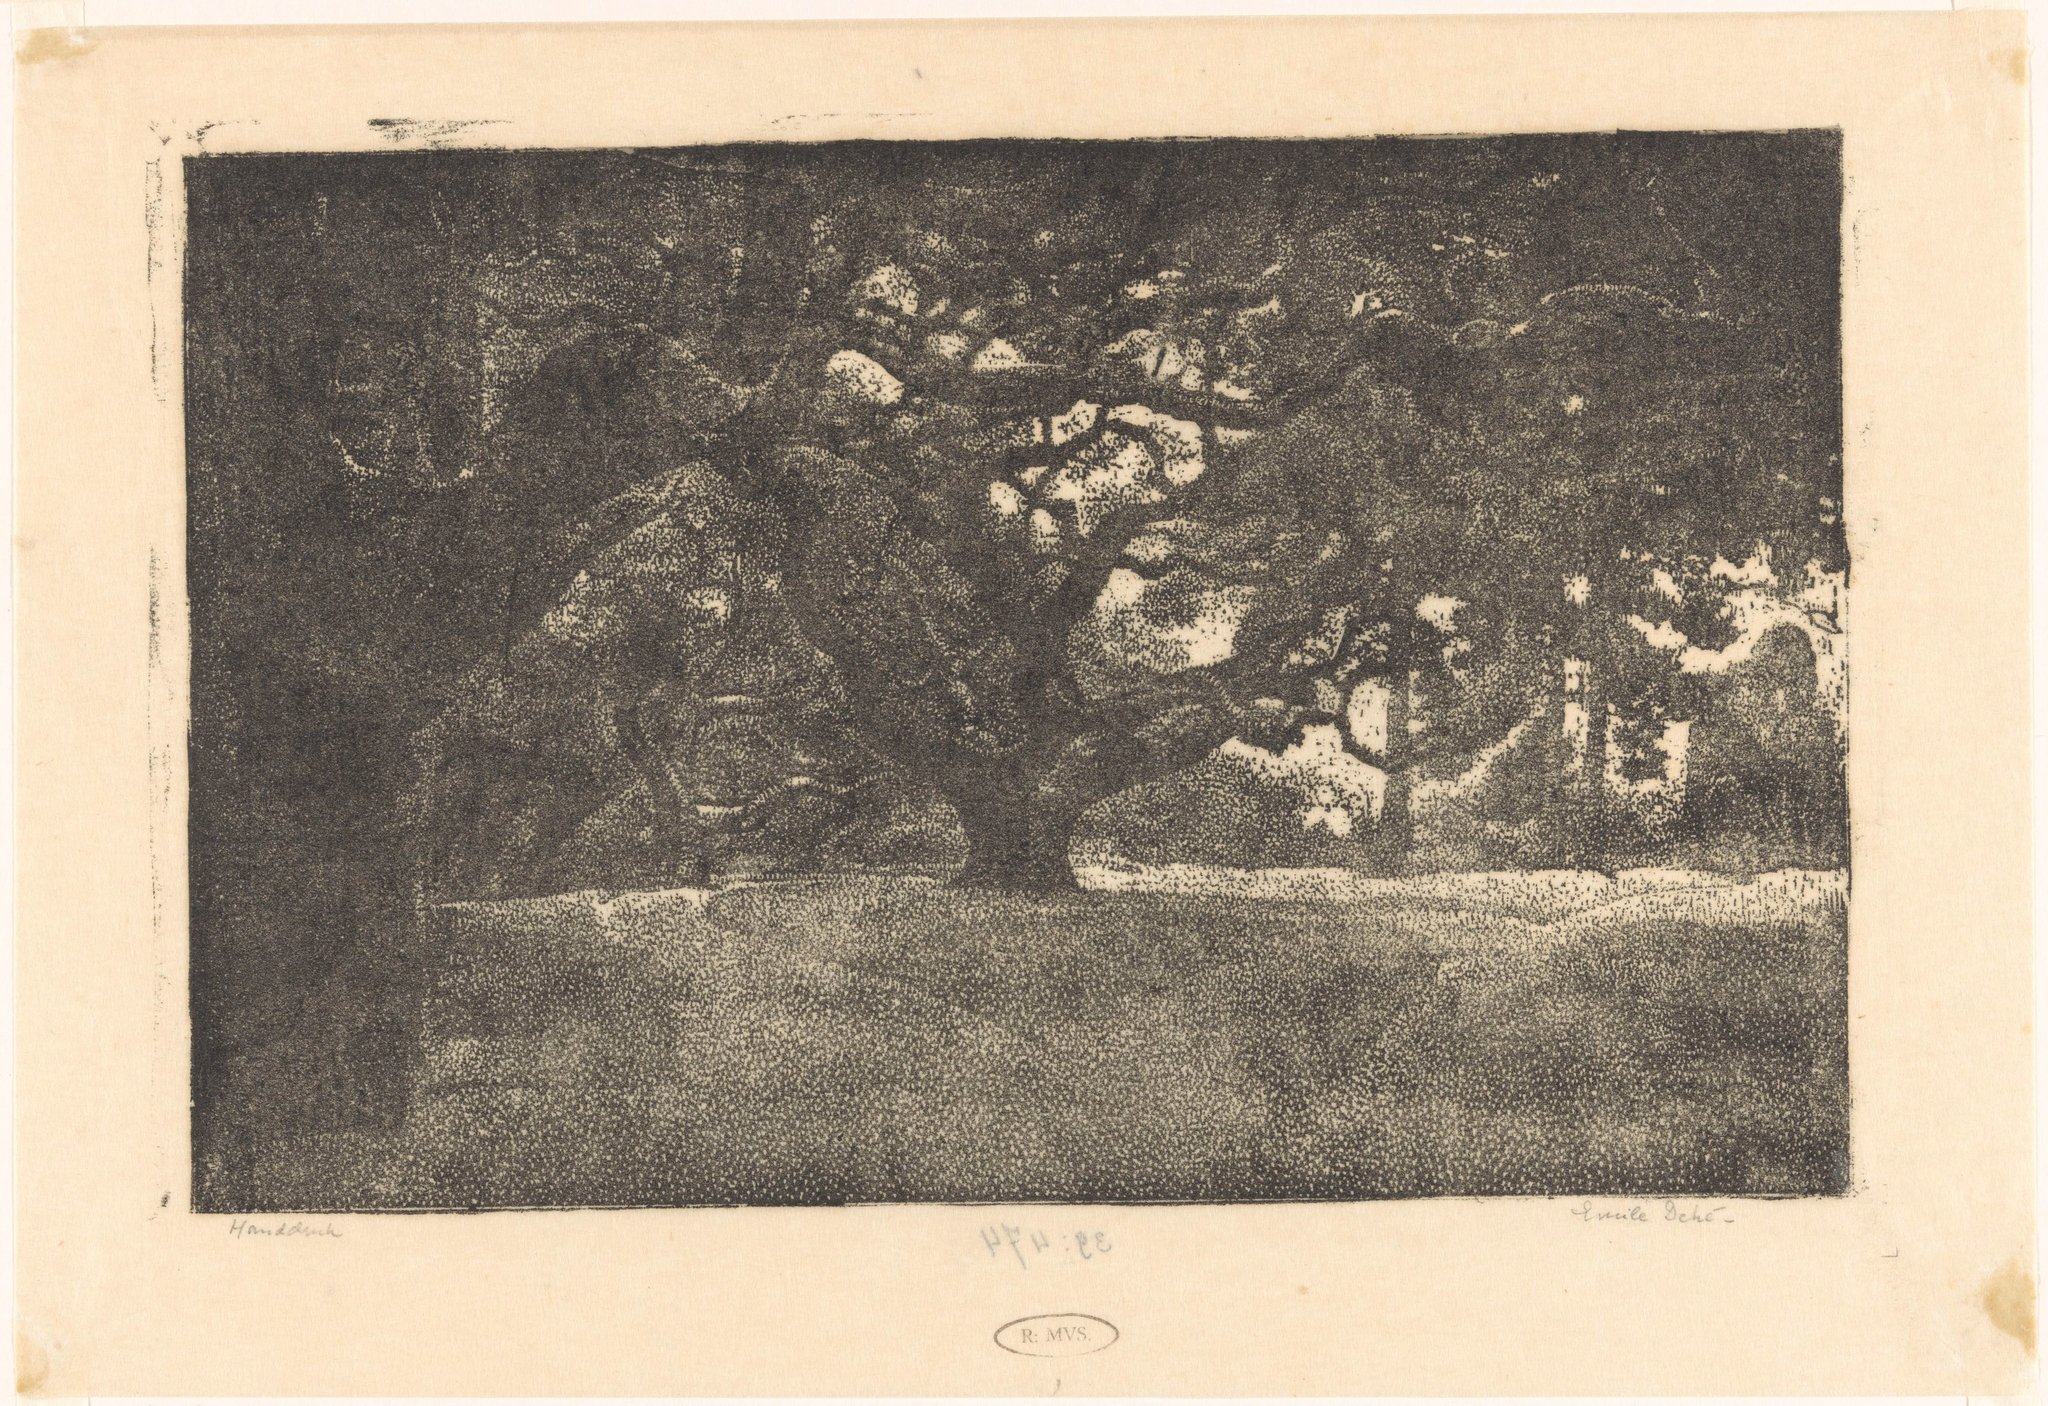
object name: print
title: Bos met loofbomen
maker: emilius wilhelmus dehé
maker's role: draughtsman, print maker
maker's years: 1886-1947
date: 1896-1939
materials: paper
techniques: woodcut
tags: forest, wood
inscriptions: collector's mark: Lugt 2228